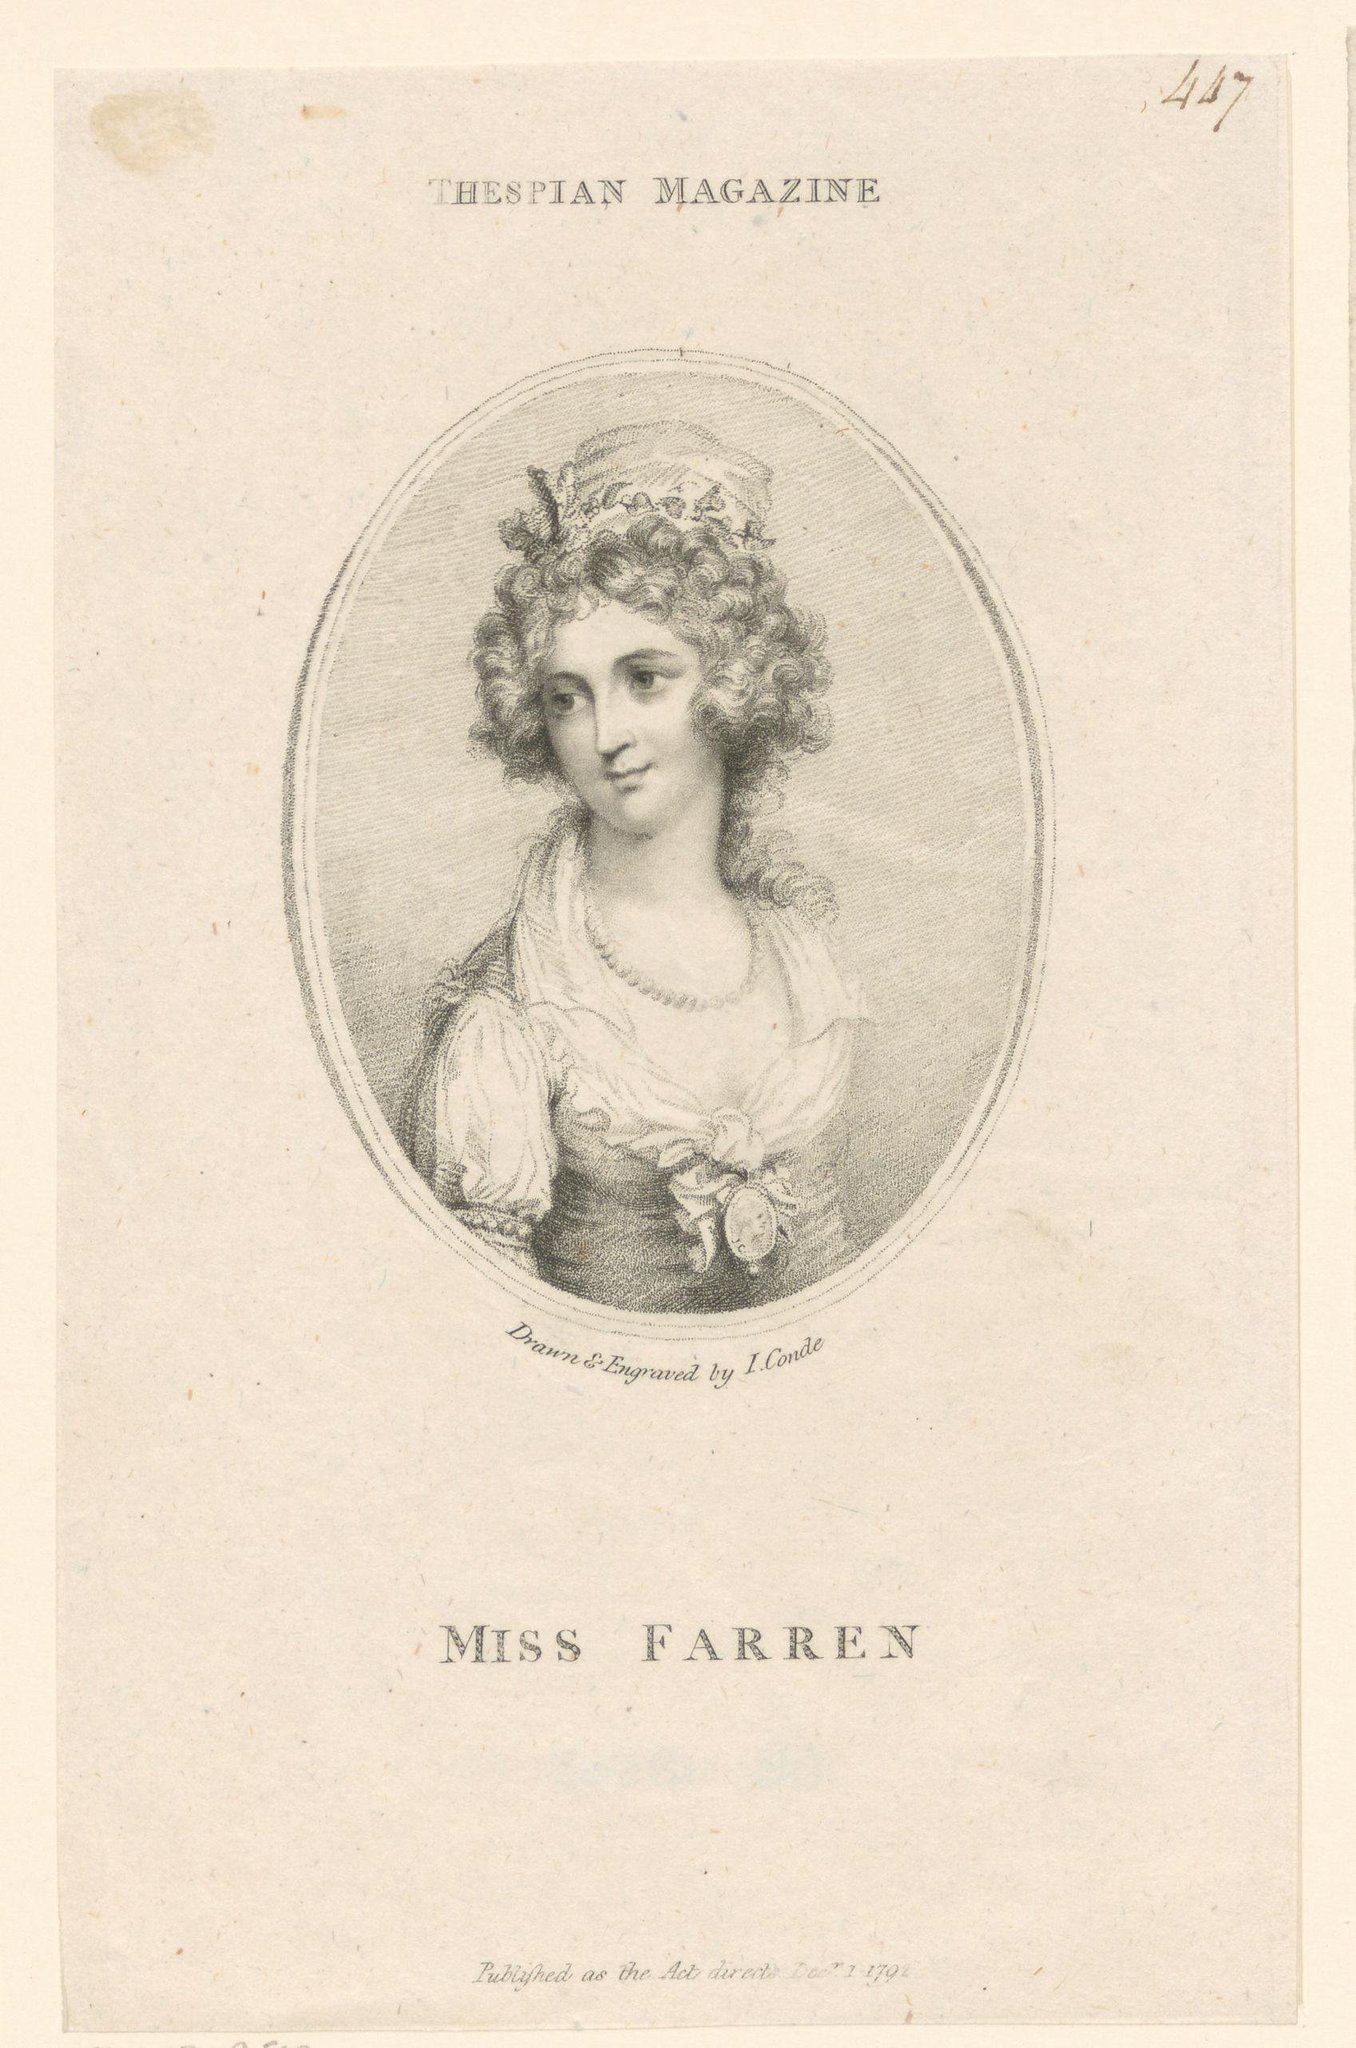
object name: print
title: Portret van Elizabeth Farren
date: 1792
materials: paper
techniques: stippling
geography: aldermanbury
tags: london, historical persons, portrait of actor, actress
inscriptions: collector's mark: Lugt 2228, number: ‘447’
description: Prent gebruikt in: Thespian Magazine (1793).